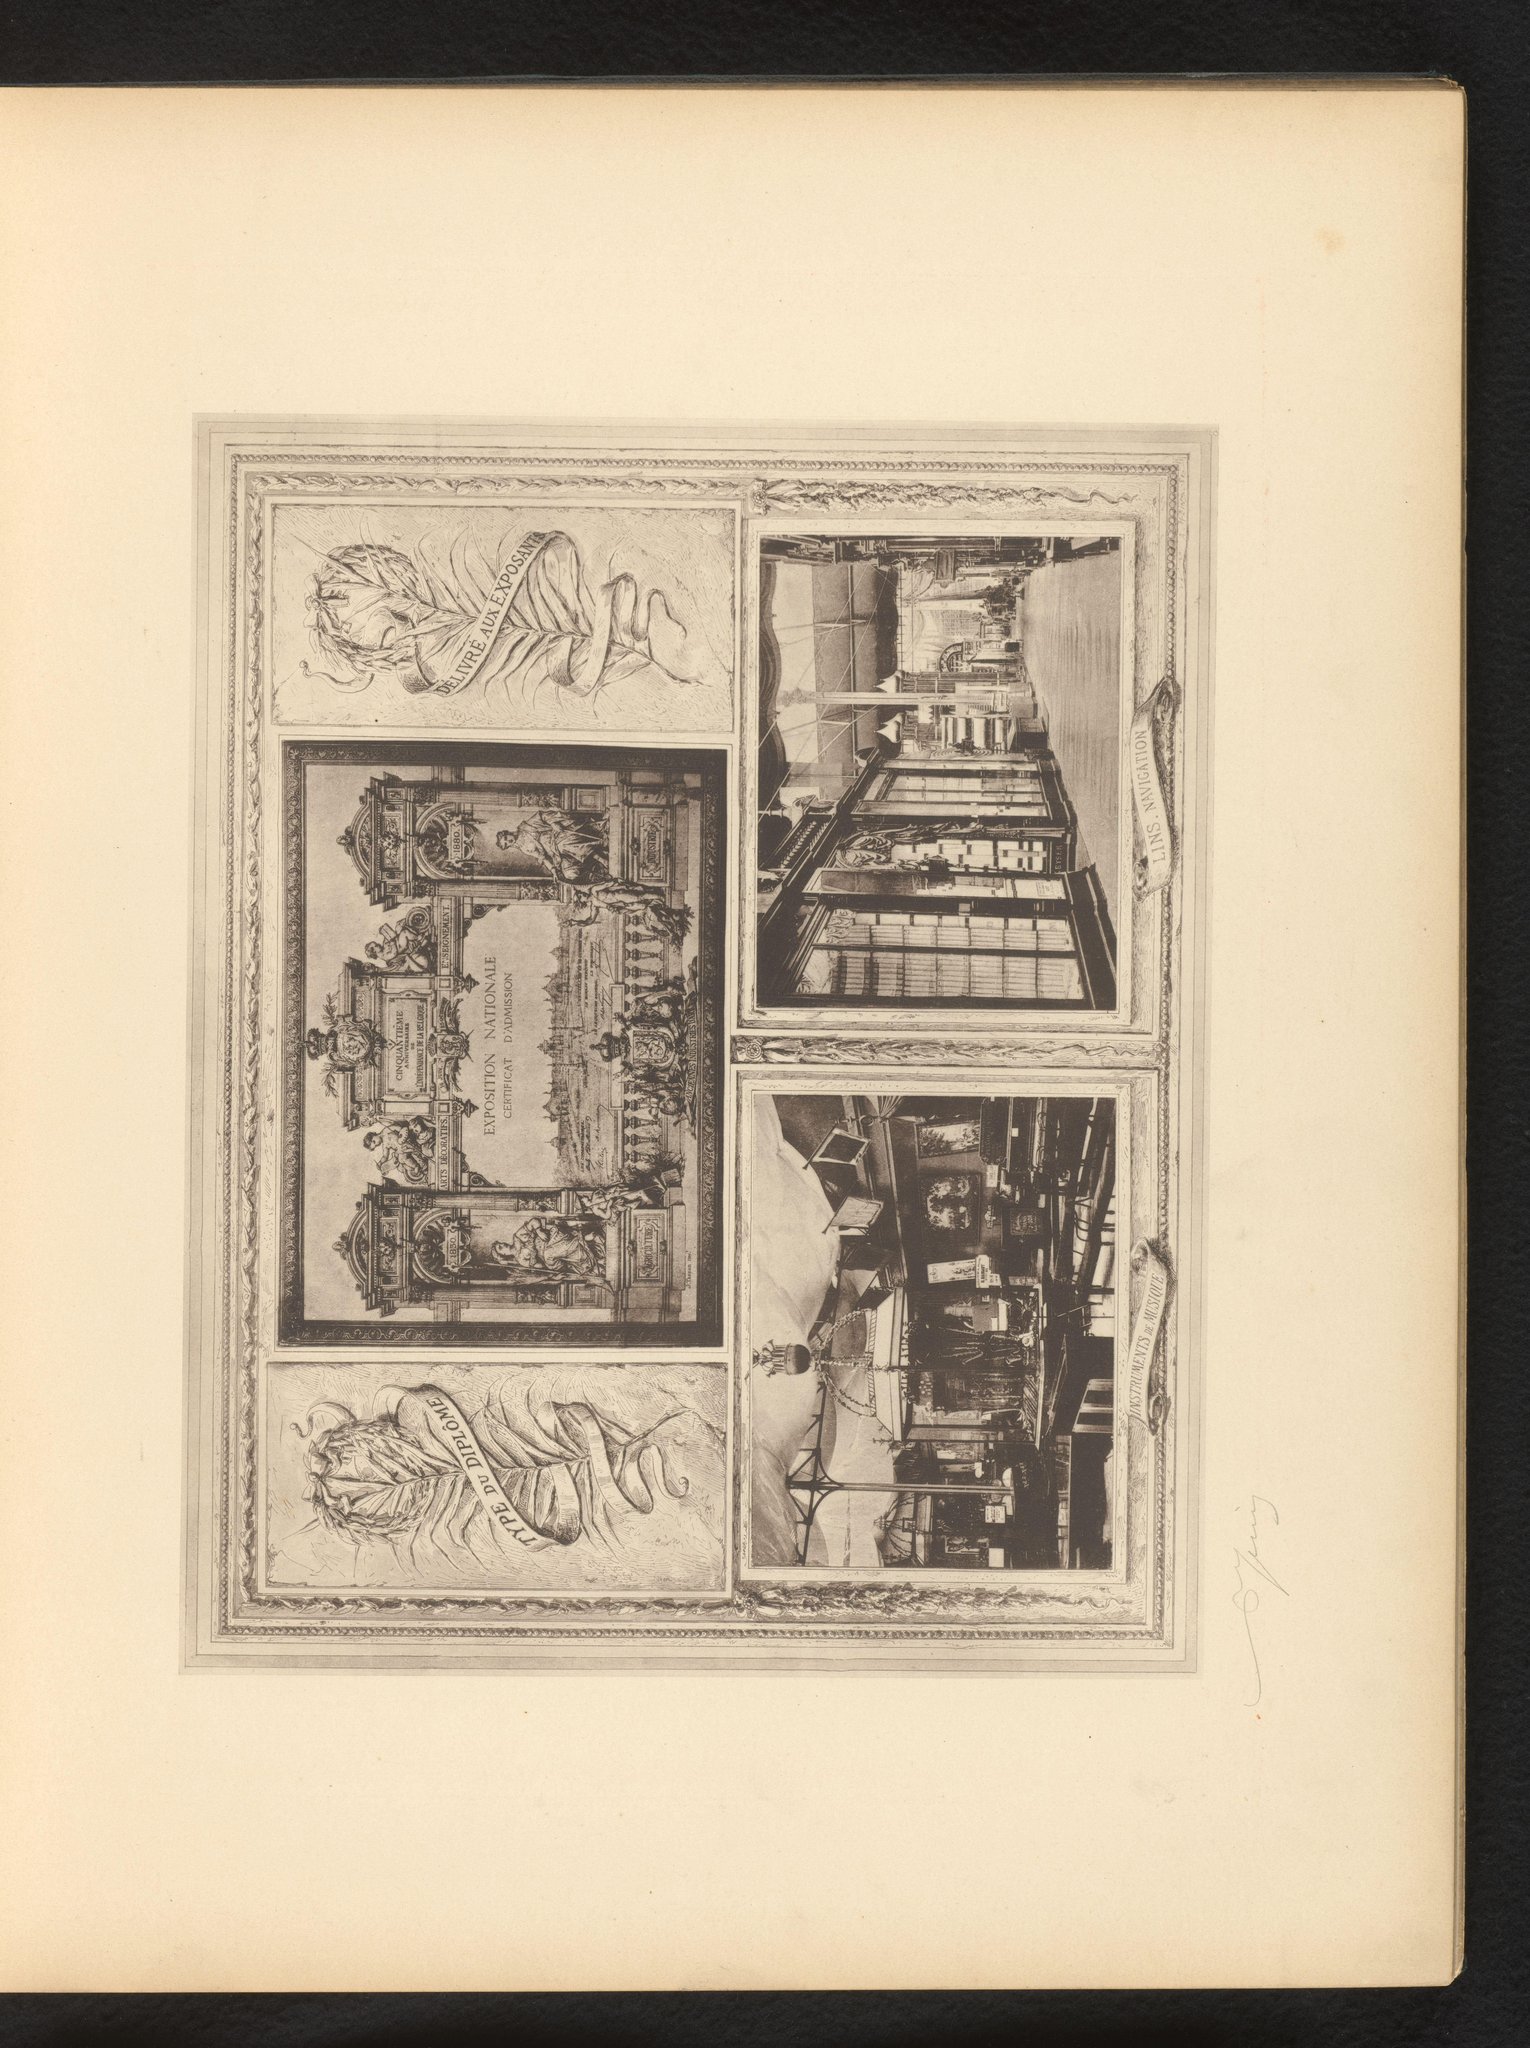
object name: photomechanical print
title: Reproductie van een gravure van de Exposition Nationale van 1880 in Brussel, waarin twee fotografische gezichten op de expositie zijn verwerkt, door Armand Heins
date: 1881-1882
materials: paper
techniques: photograph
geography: brussels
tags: trade exhibition, industries fair, brussels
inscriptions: name: ‘Heins’